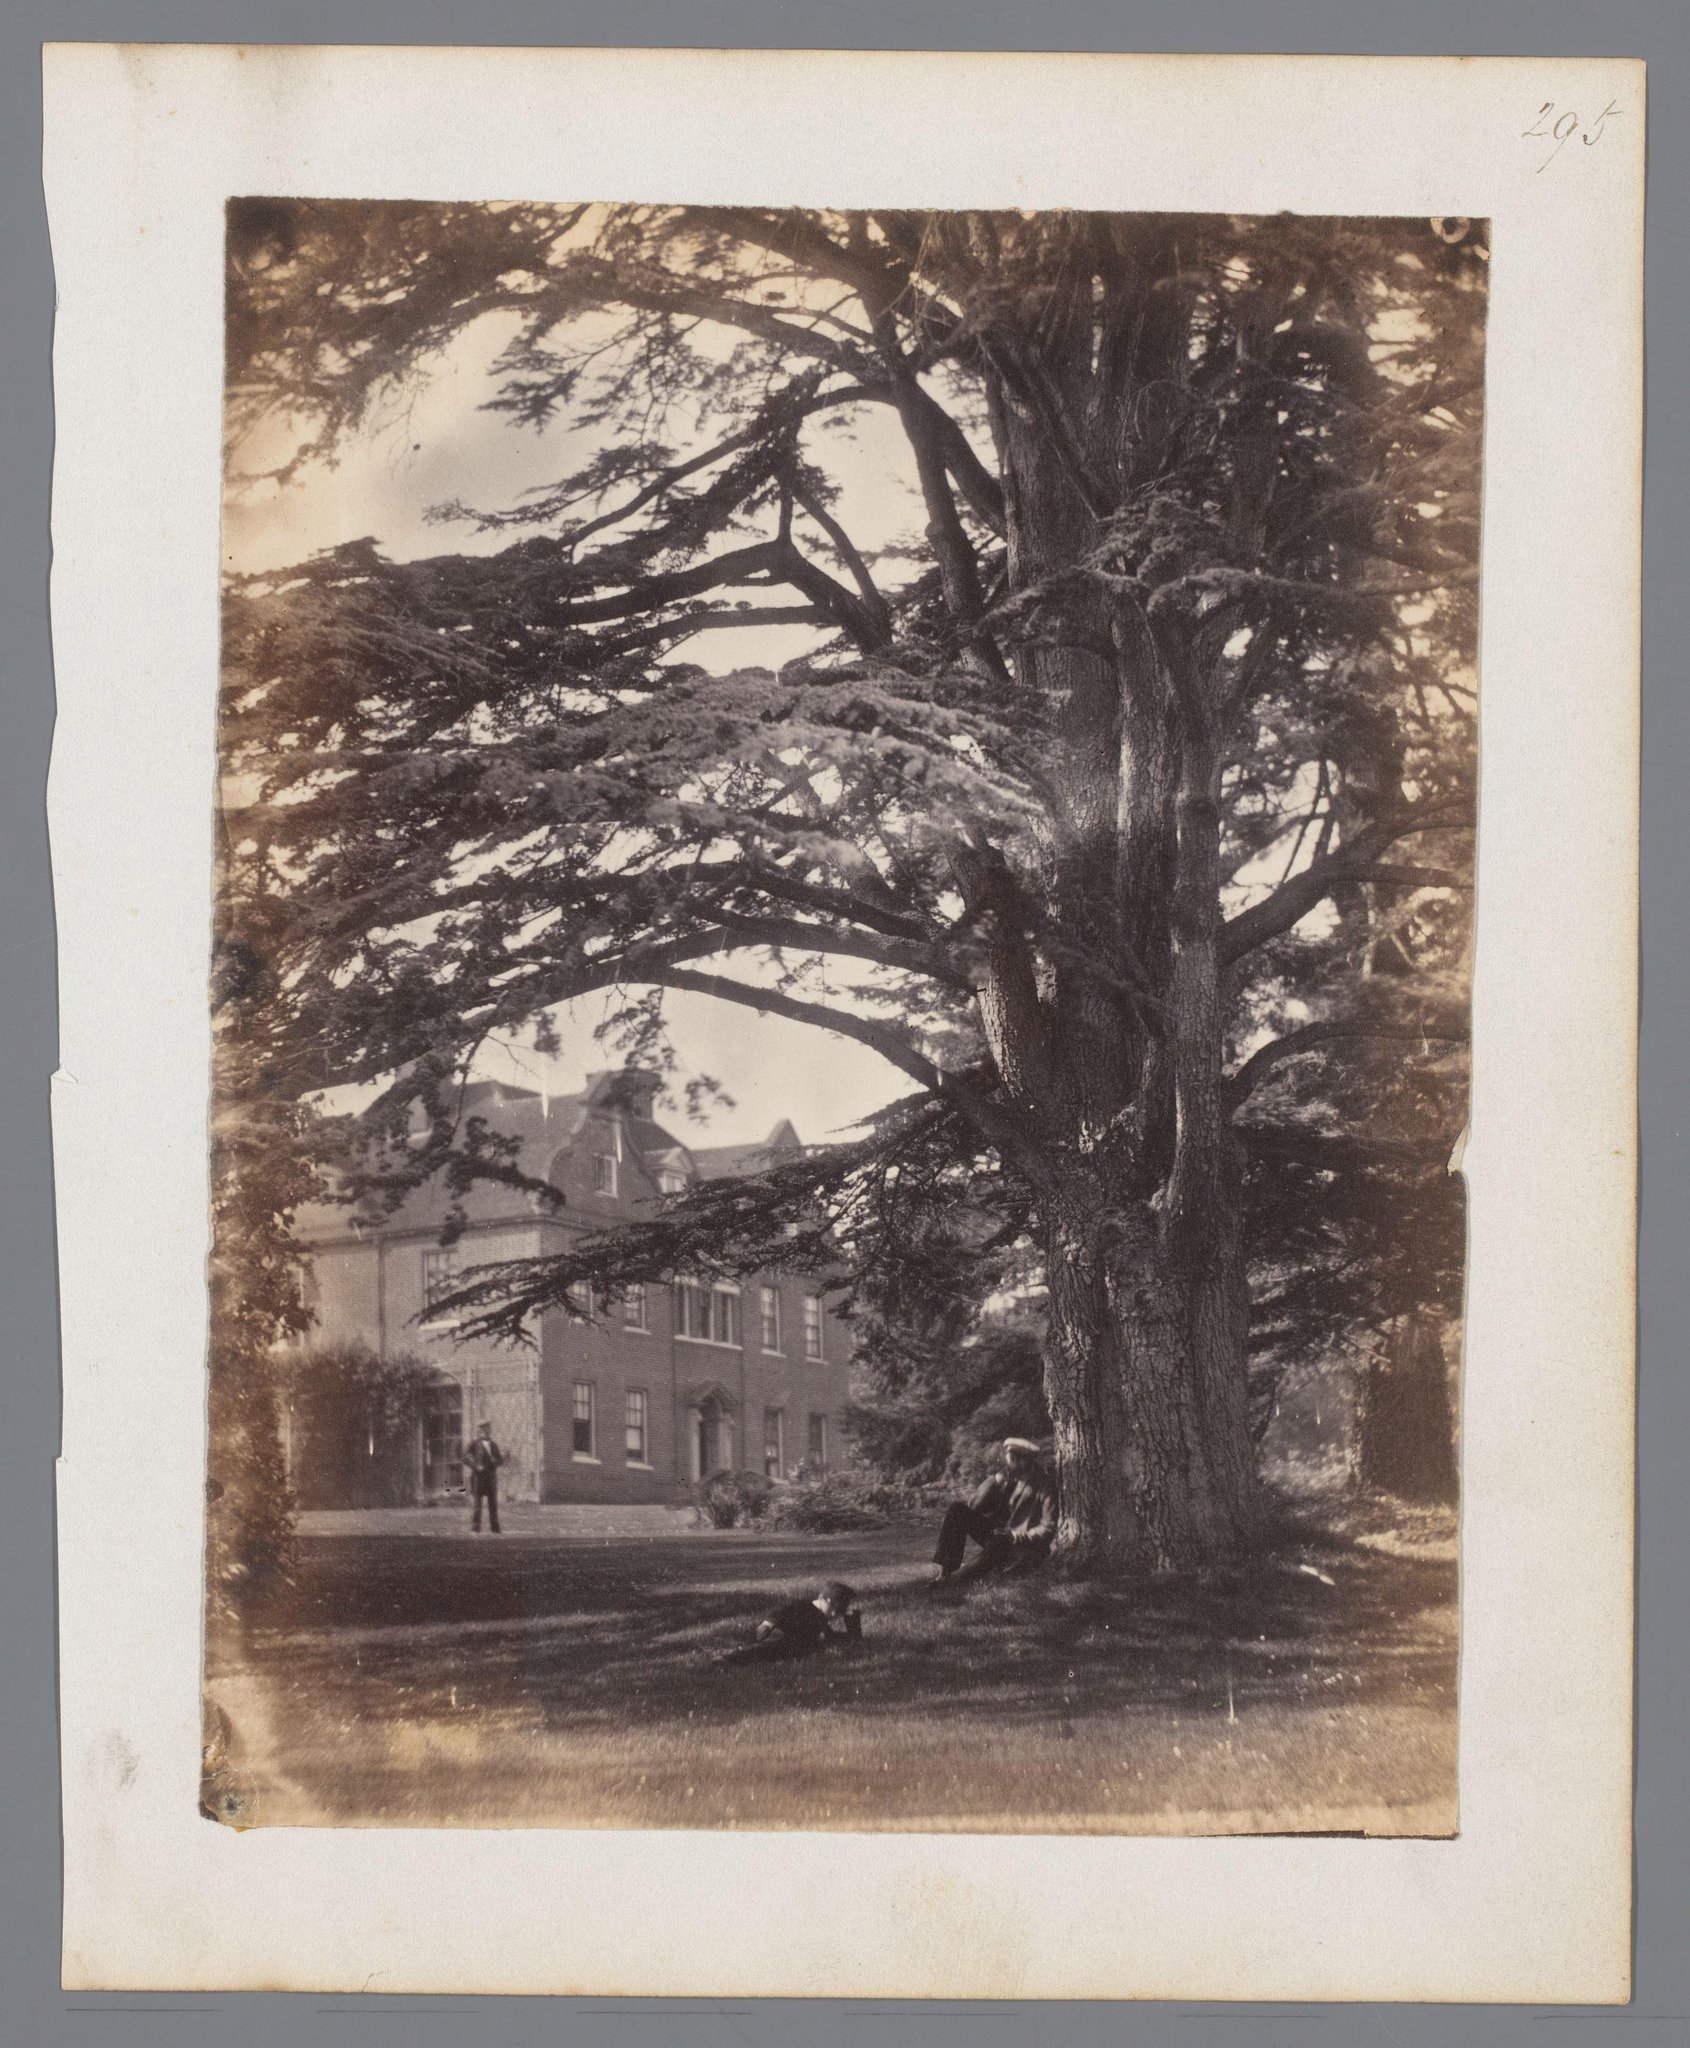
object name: photograph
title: Gezicht op een grote boom en een huis, met drie figuren op de voorgrond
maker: Anonymous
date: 1865-1885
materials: paper, photographic support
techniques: albumen print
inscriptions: number: ‘295’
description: Gezicht op een grote boom en een huis, met drie figuren op de voorgrond. Een man met baard en pet leunt tegen de stam van de boom, een jongen ligt er op zijn zij voor, richting het huis staat een man in het zonlicht.